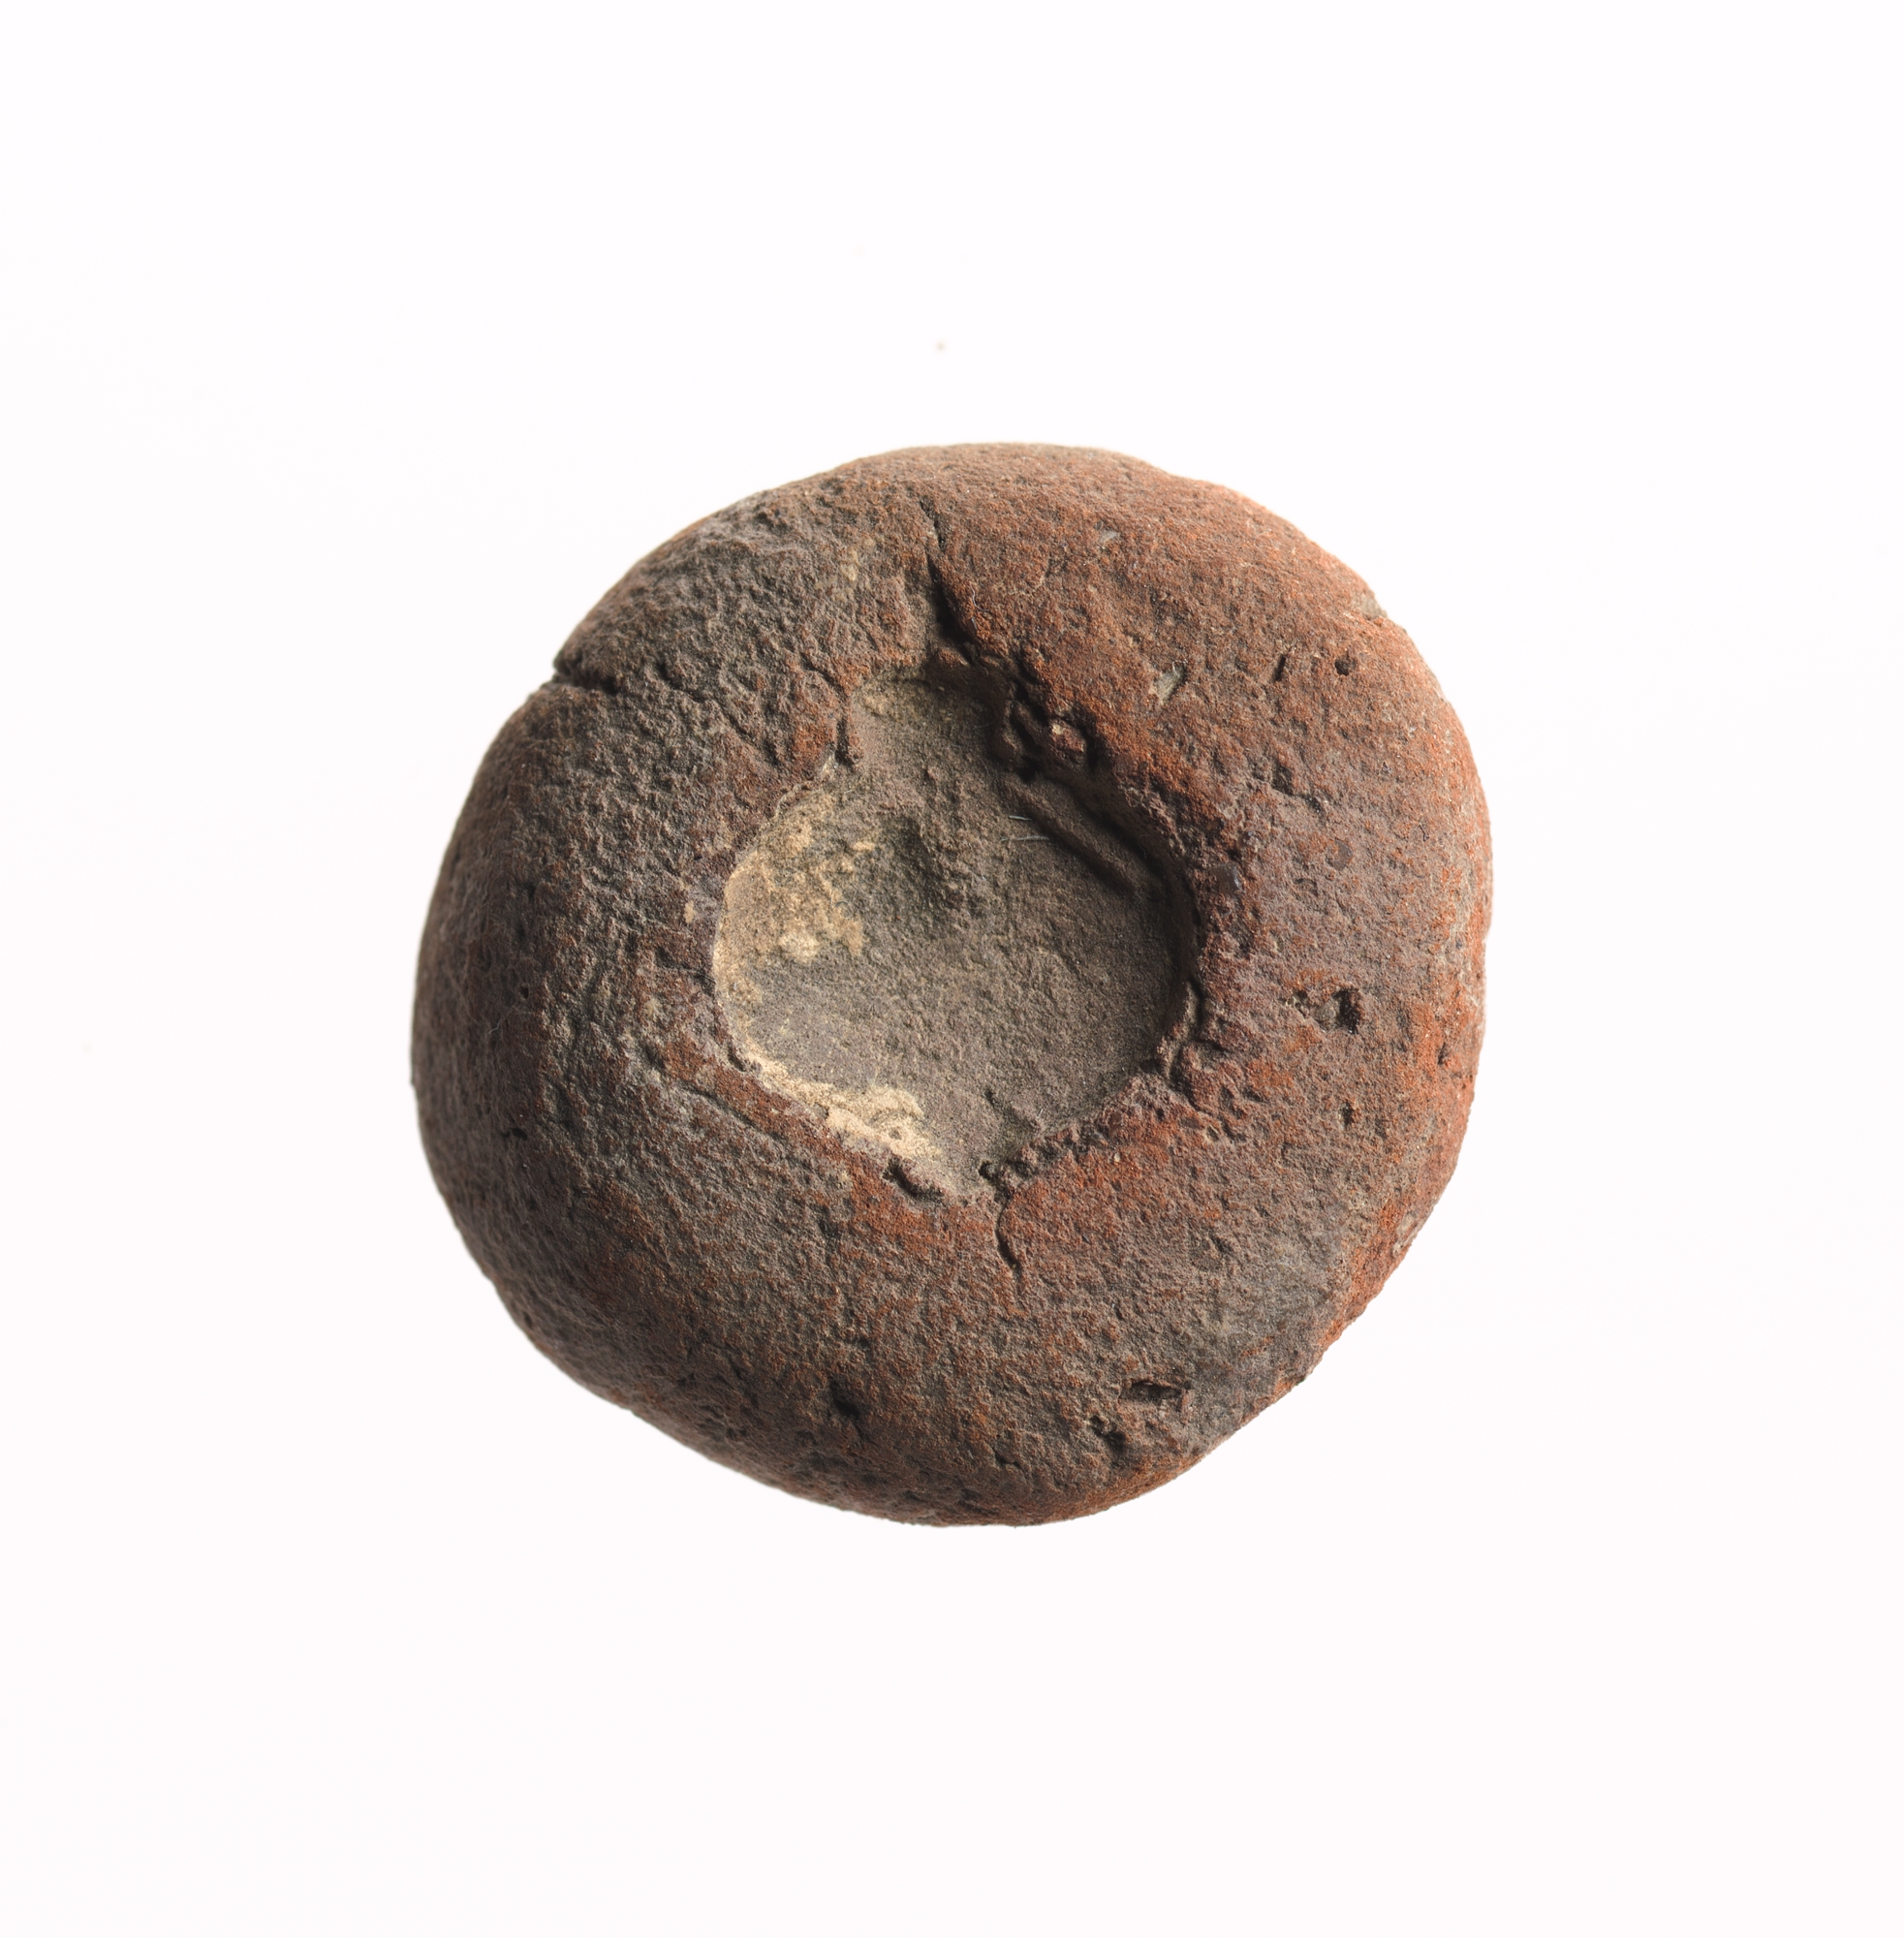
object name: mold, persea fruit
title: Mold for a Persea Fruit Pendant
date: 1353-1336 BCE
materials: pottery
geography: egypt